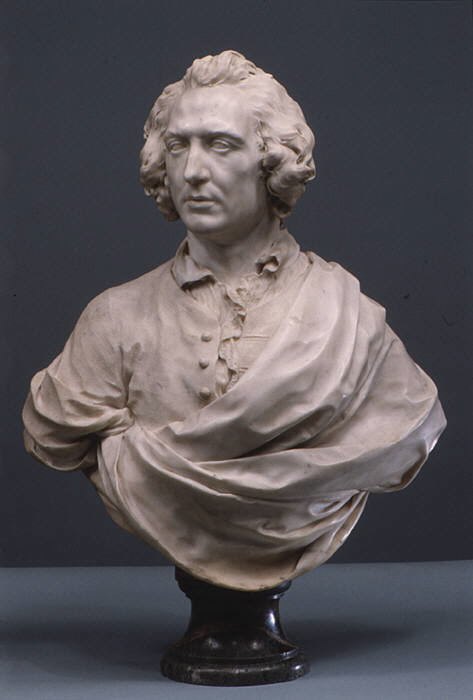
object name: bust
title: Bust of an Englishman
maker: peter anton von verschaffelt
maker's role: artist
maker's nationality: flemish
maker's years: 1710-1793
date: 1740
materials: marble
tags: men,portraits